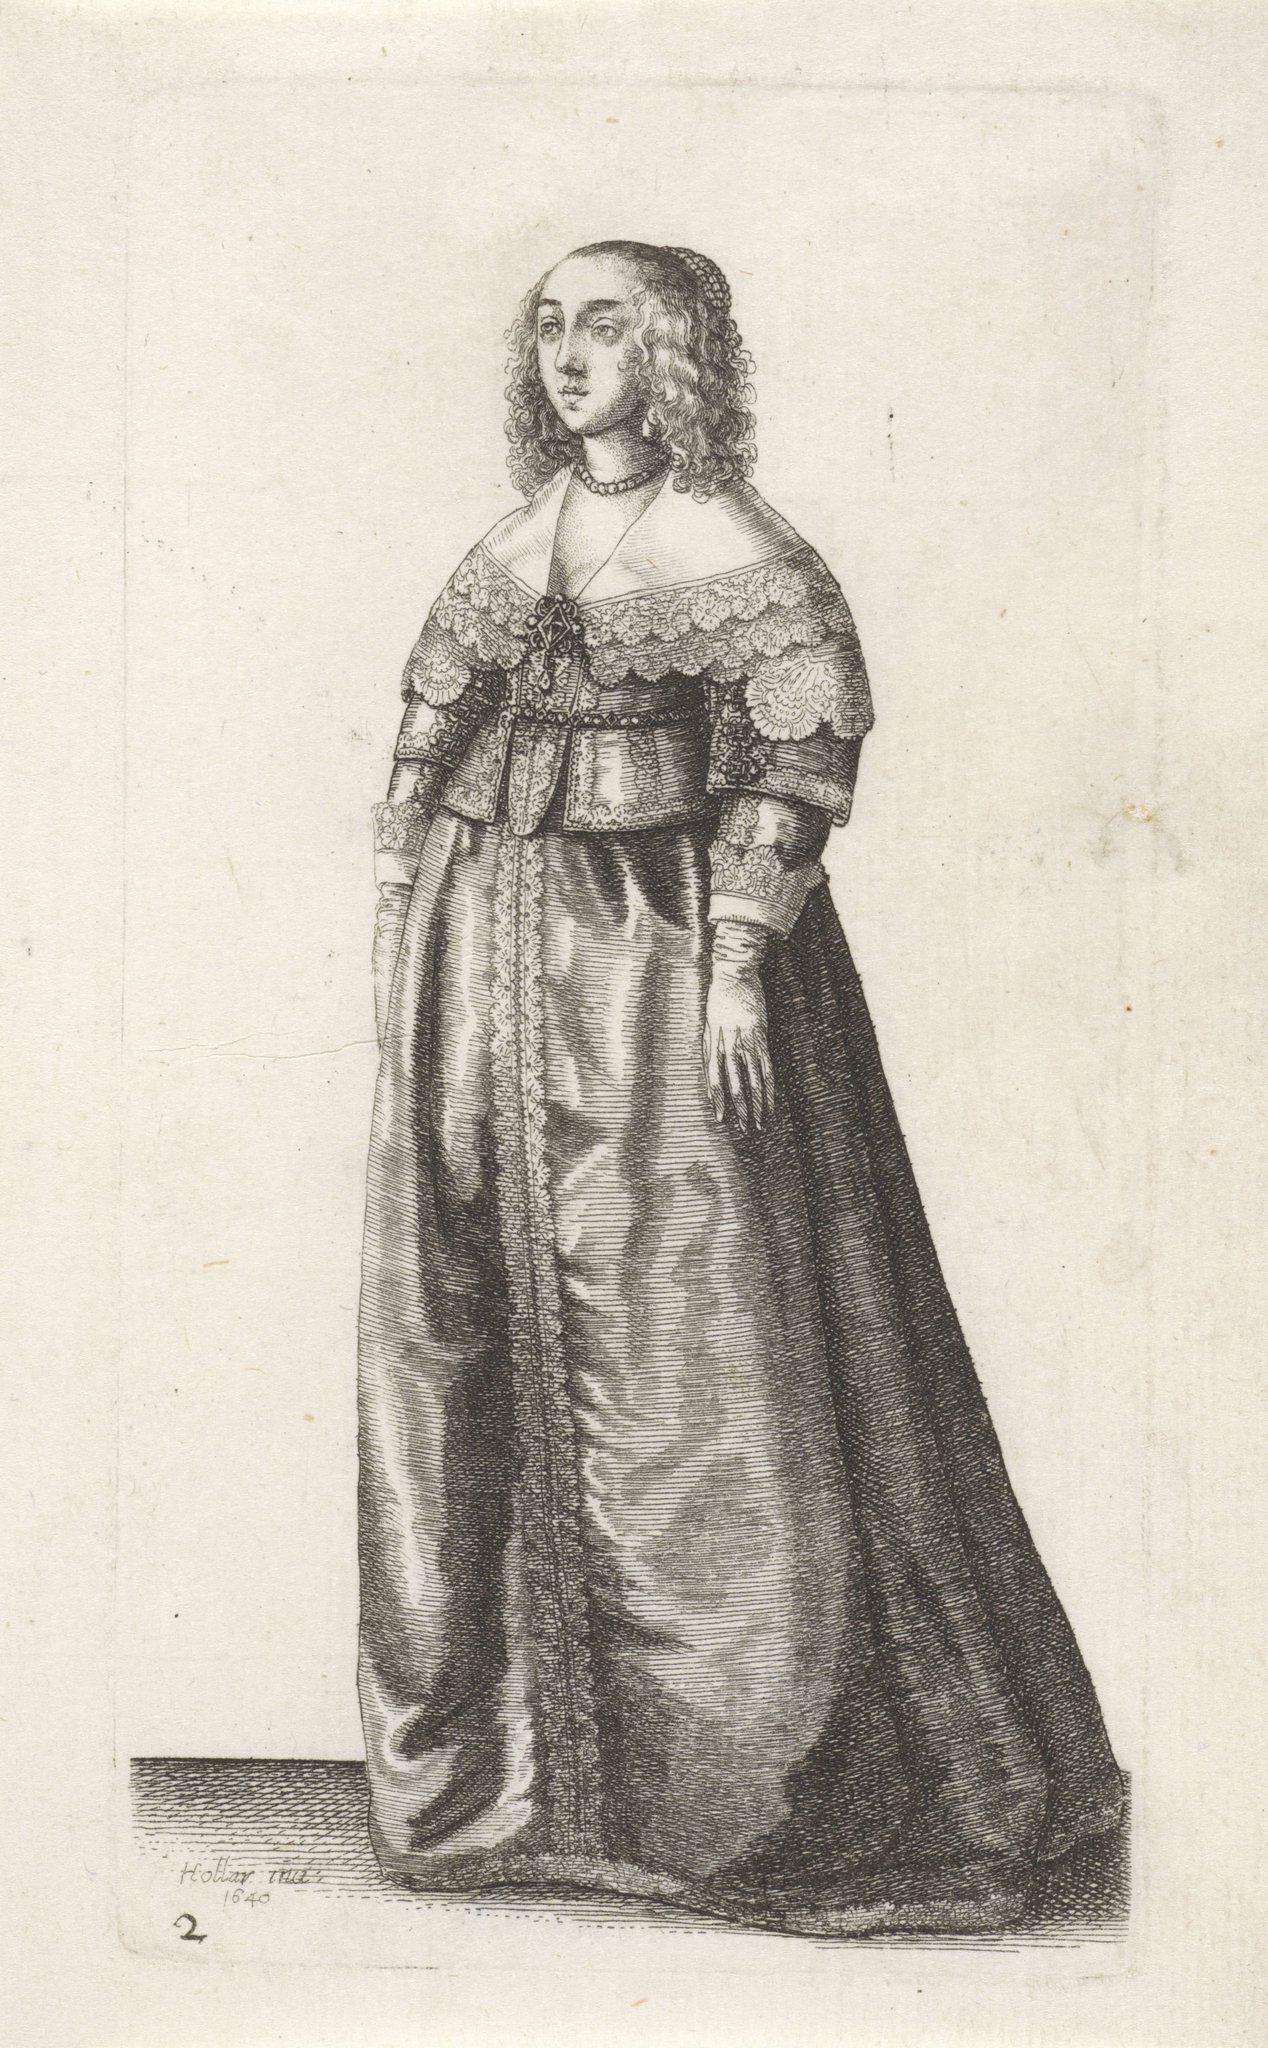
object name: costume print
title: Ornatus Muliebris Anglicanus (The Clothing of English Women)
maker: wenceslaus hollar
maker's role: draughtsman, print maker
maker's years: 1607-1677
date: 1640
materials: paper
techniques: etching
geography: london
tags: precious and semiprecious stones: diamond, europeans: englishmen (+ women), belt, girdle, waistband, styles of hairdress - aa - ~ women, neck-gear: collar (+ women's clothes), clothes covering the entire body (+ women's clothes), pearl; pearl necklace (+ women's clothes), england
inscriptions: number: ‘2’, collector's mark: Lugt 654, signature and date: ‘Hollar inv./1640’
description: The diversity of women’s apparel in England is illustrated in this extensive costume series. Hollar represented women from all ranks of society, from the humble countrywoman 1 to the elegant noblewoman 2. The more fashionable costumes are based on eyewitness observation of the ladies at the court of the Earl of Arundel, Hollar’s primary patron. They are therefore among the more reliable visual sources for costume historians.